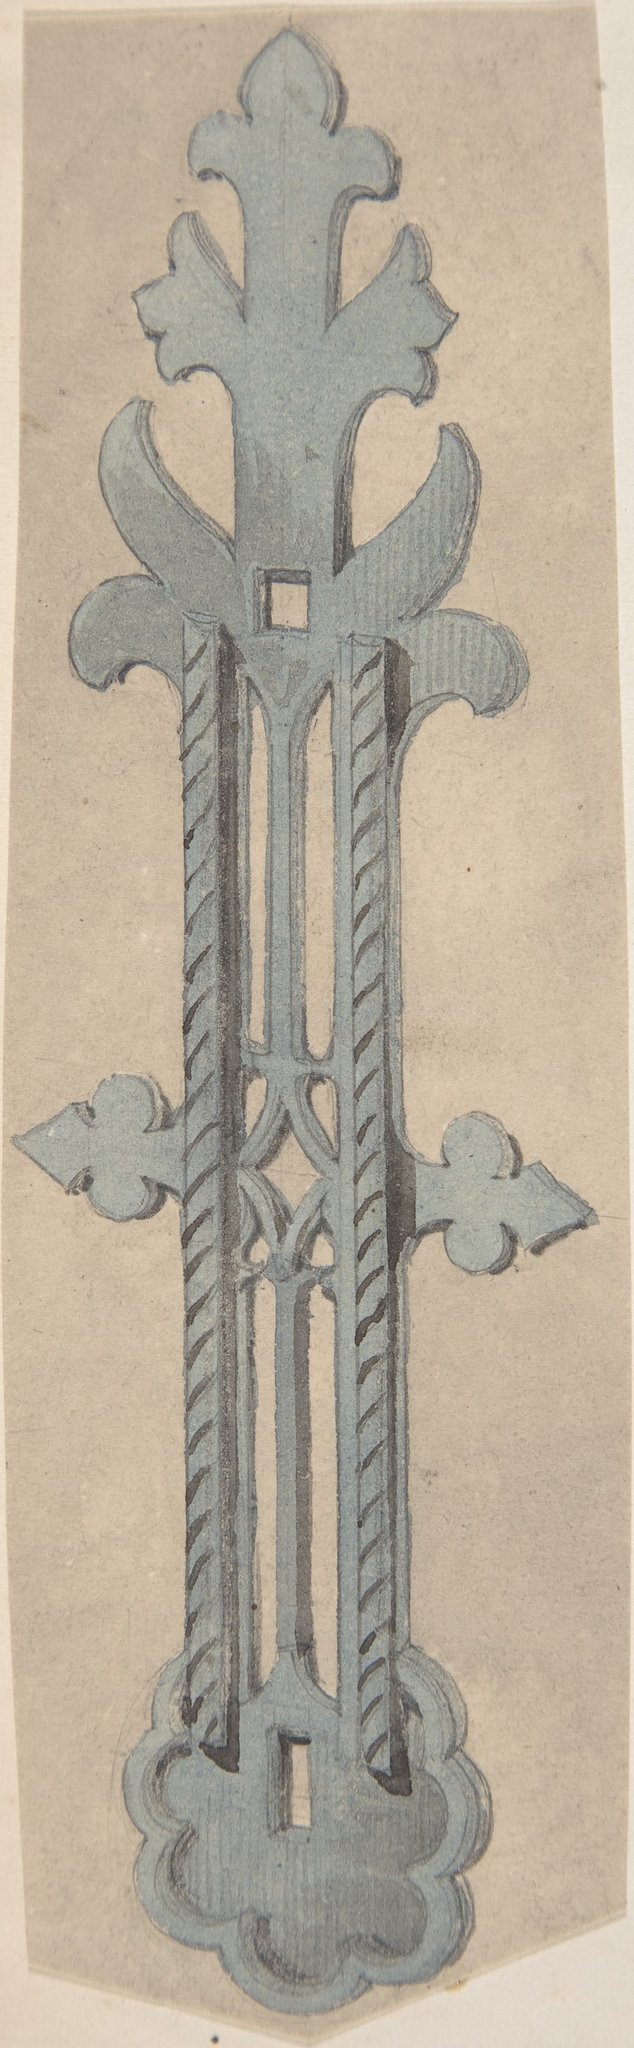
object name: drawing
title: Metal Doorplate for Church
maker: anonymous, british, 19th century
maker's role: artist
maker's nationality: british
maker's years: 1800-1900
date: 1851-1900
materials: gouache